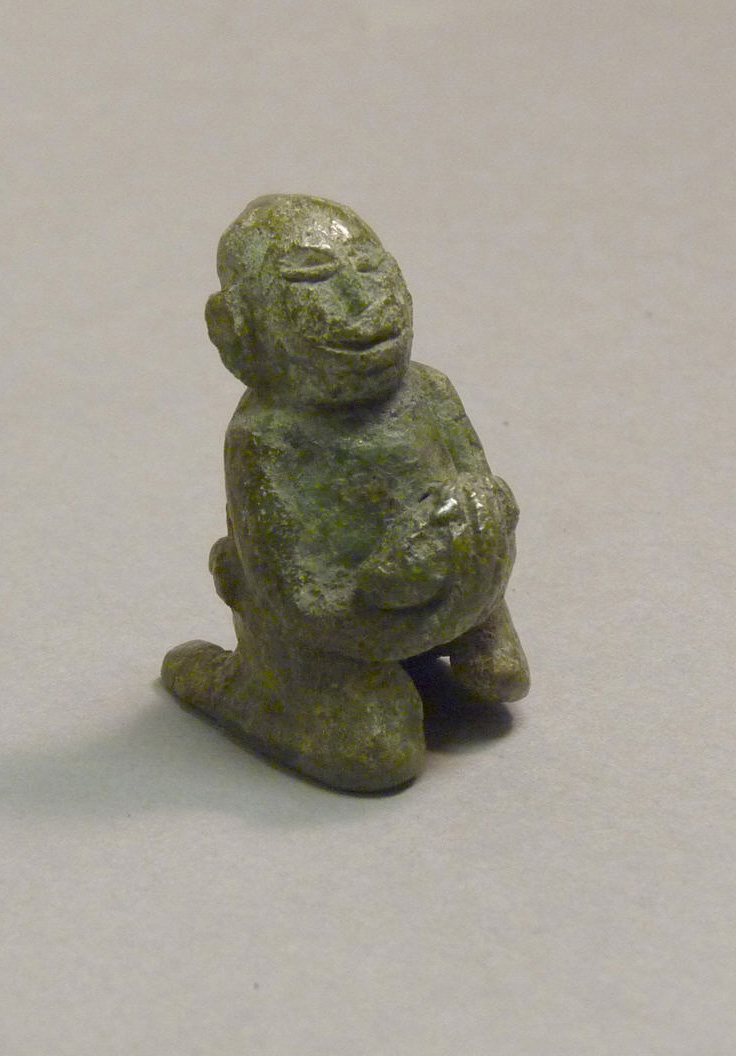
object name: figure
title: Squatting Figure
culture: indonesian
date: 500 BCE-300 CE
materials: bronze